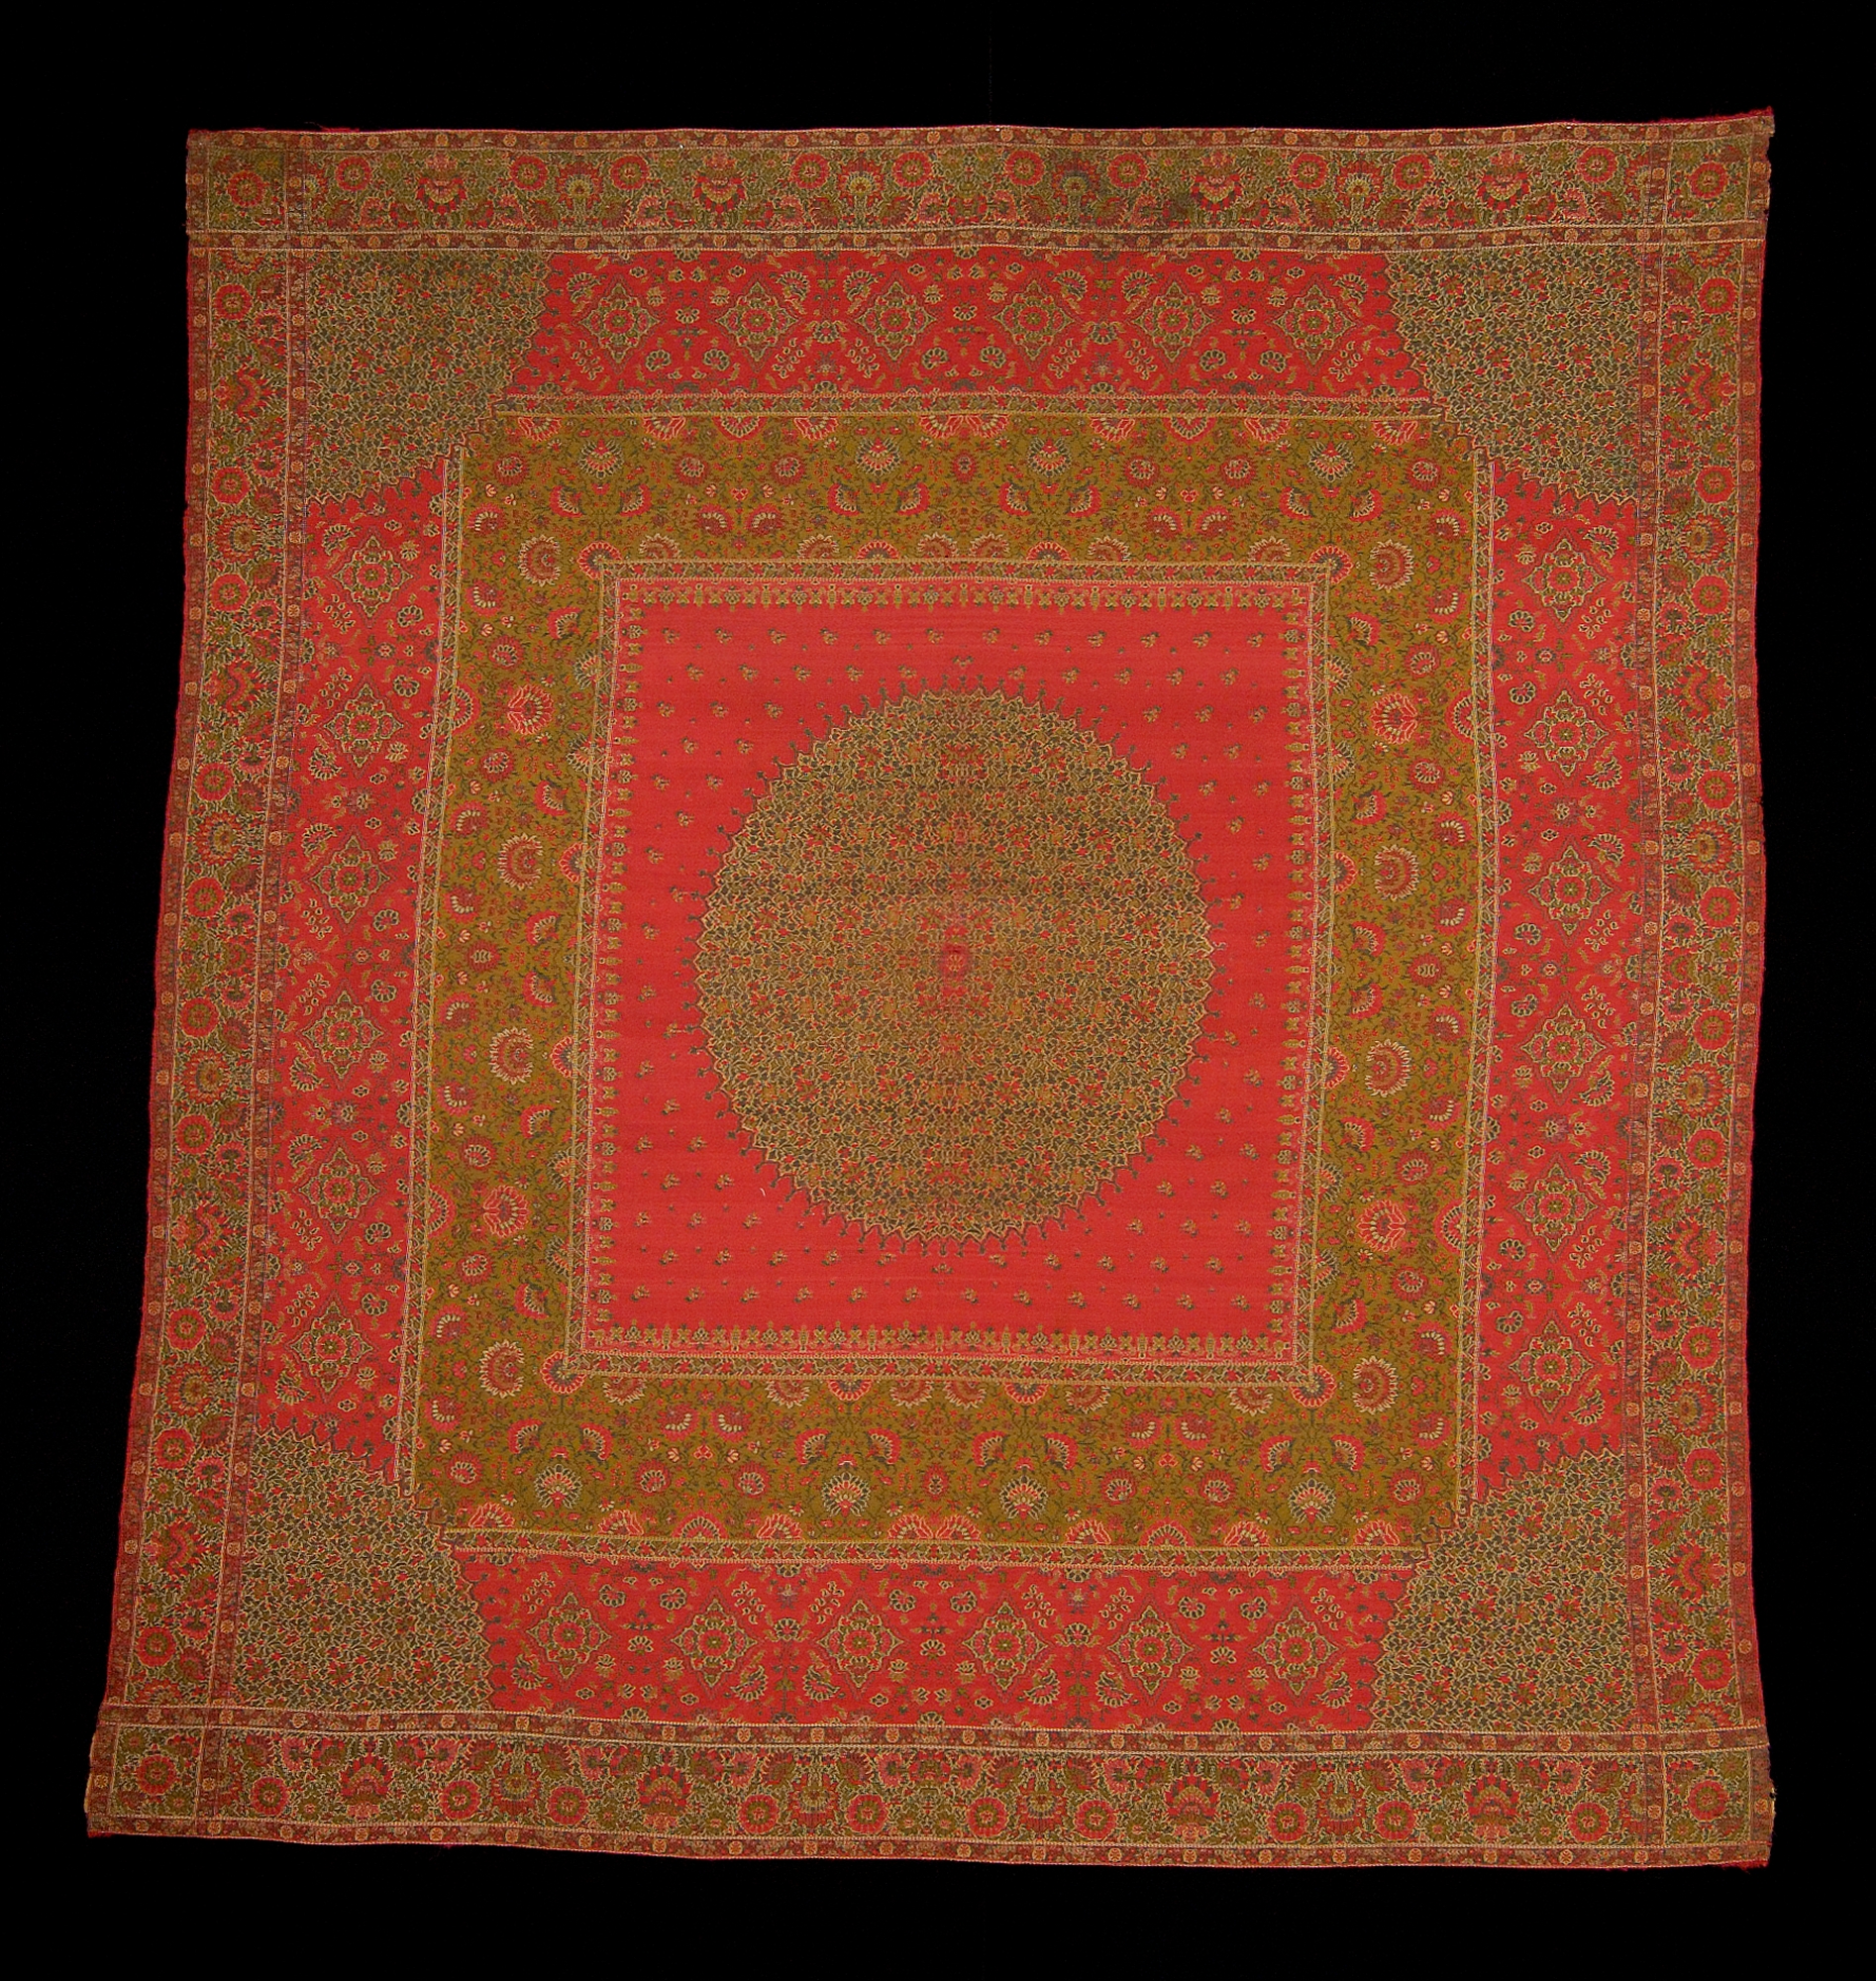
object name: shawl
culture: austrian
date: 1830-1839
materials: wool